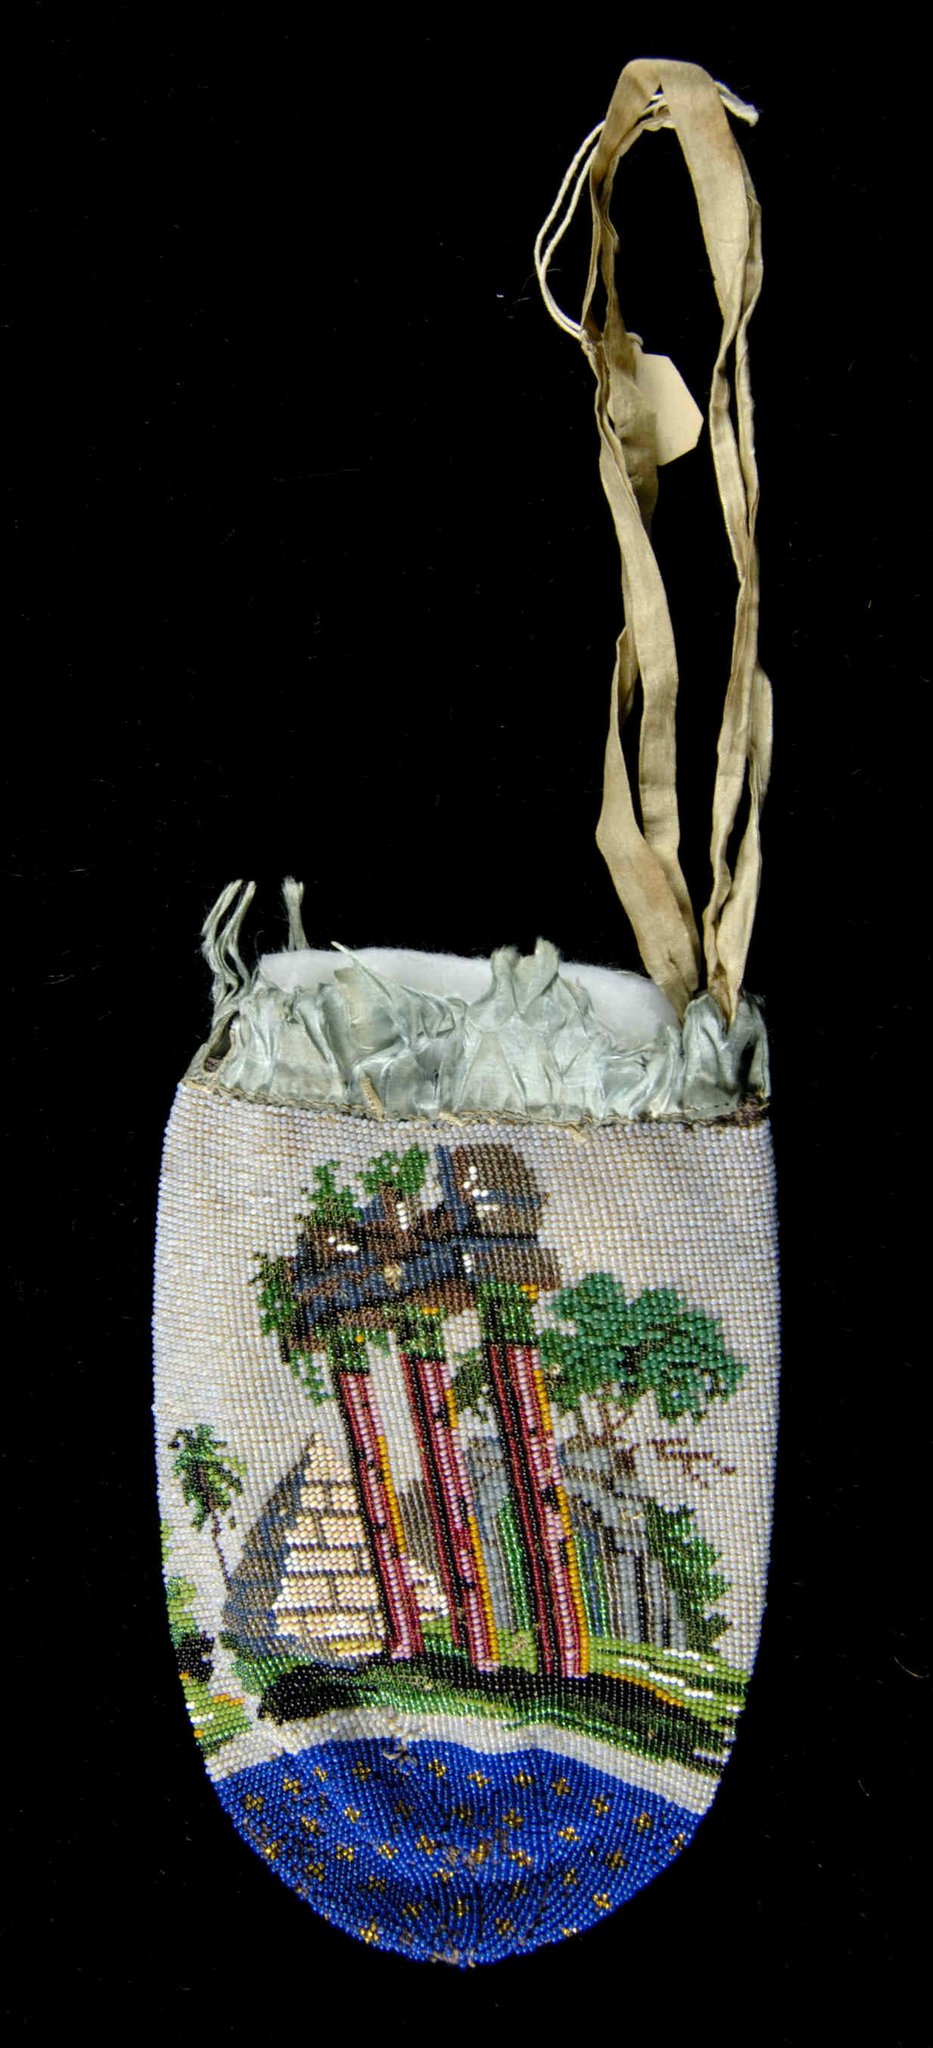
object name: pouch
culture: french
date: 1801-1825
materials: glass, leather, linen, silk